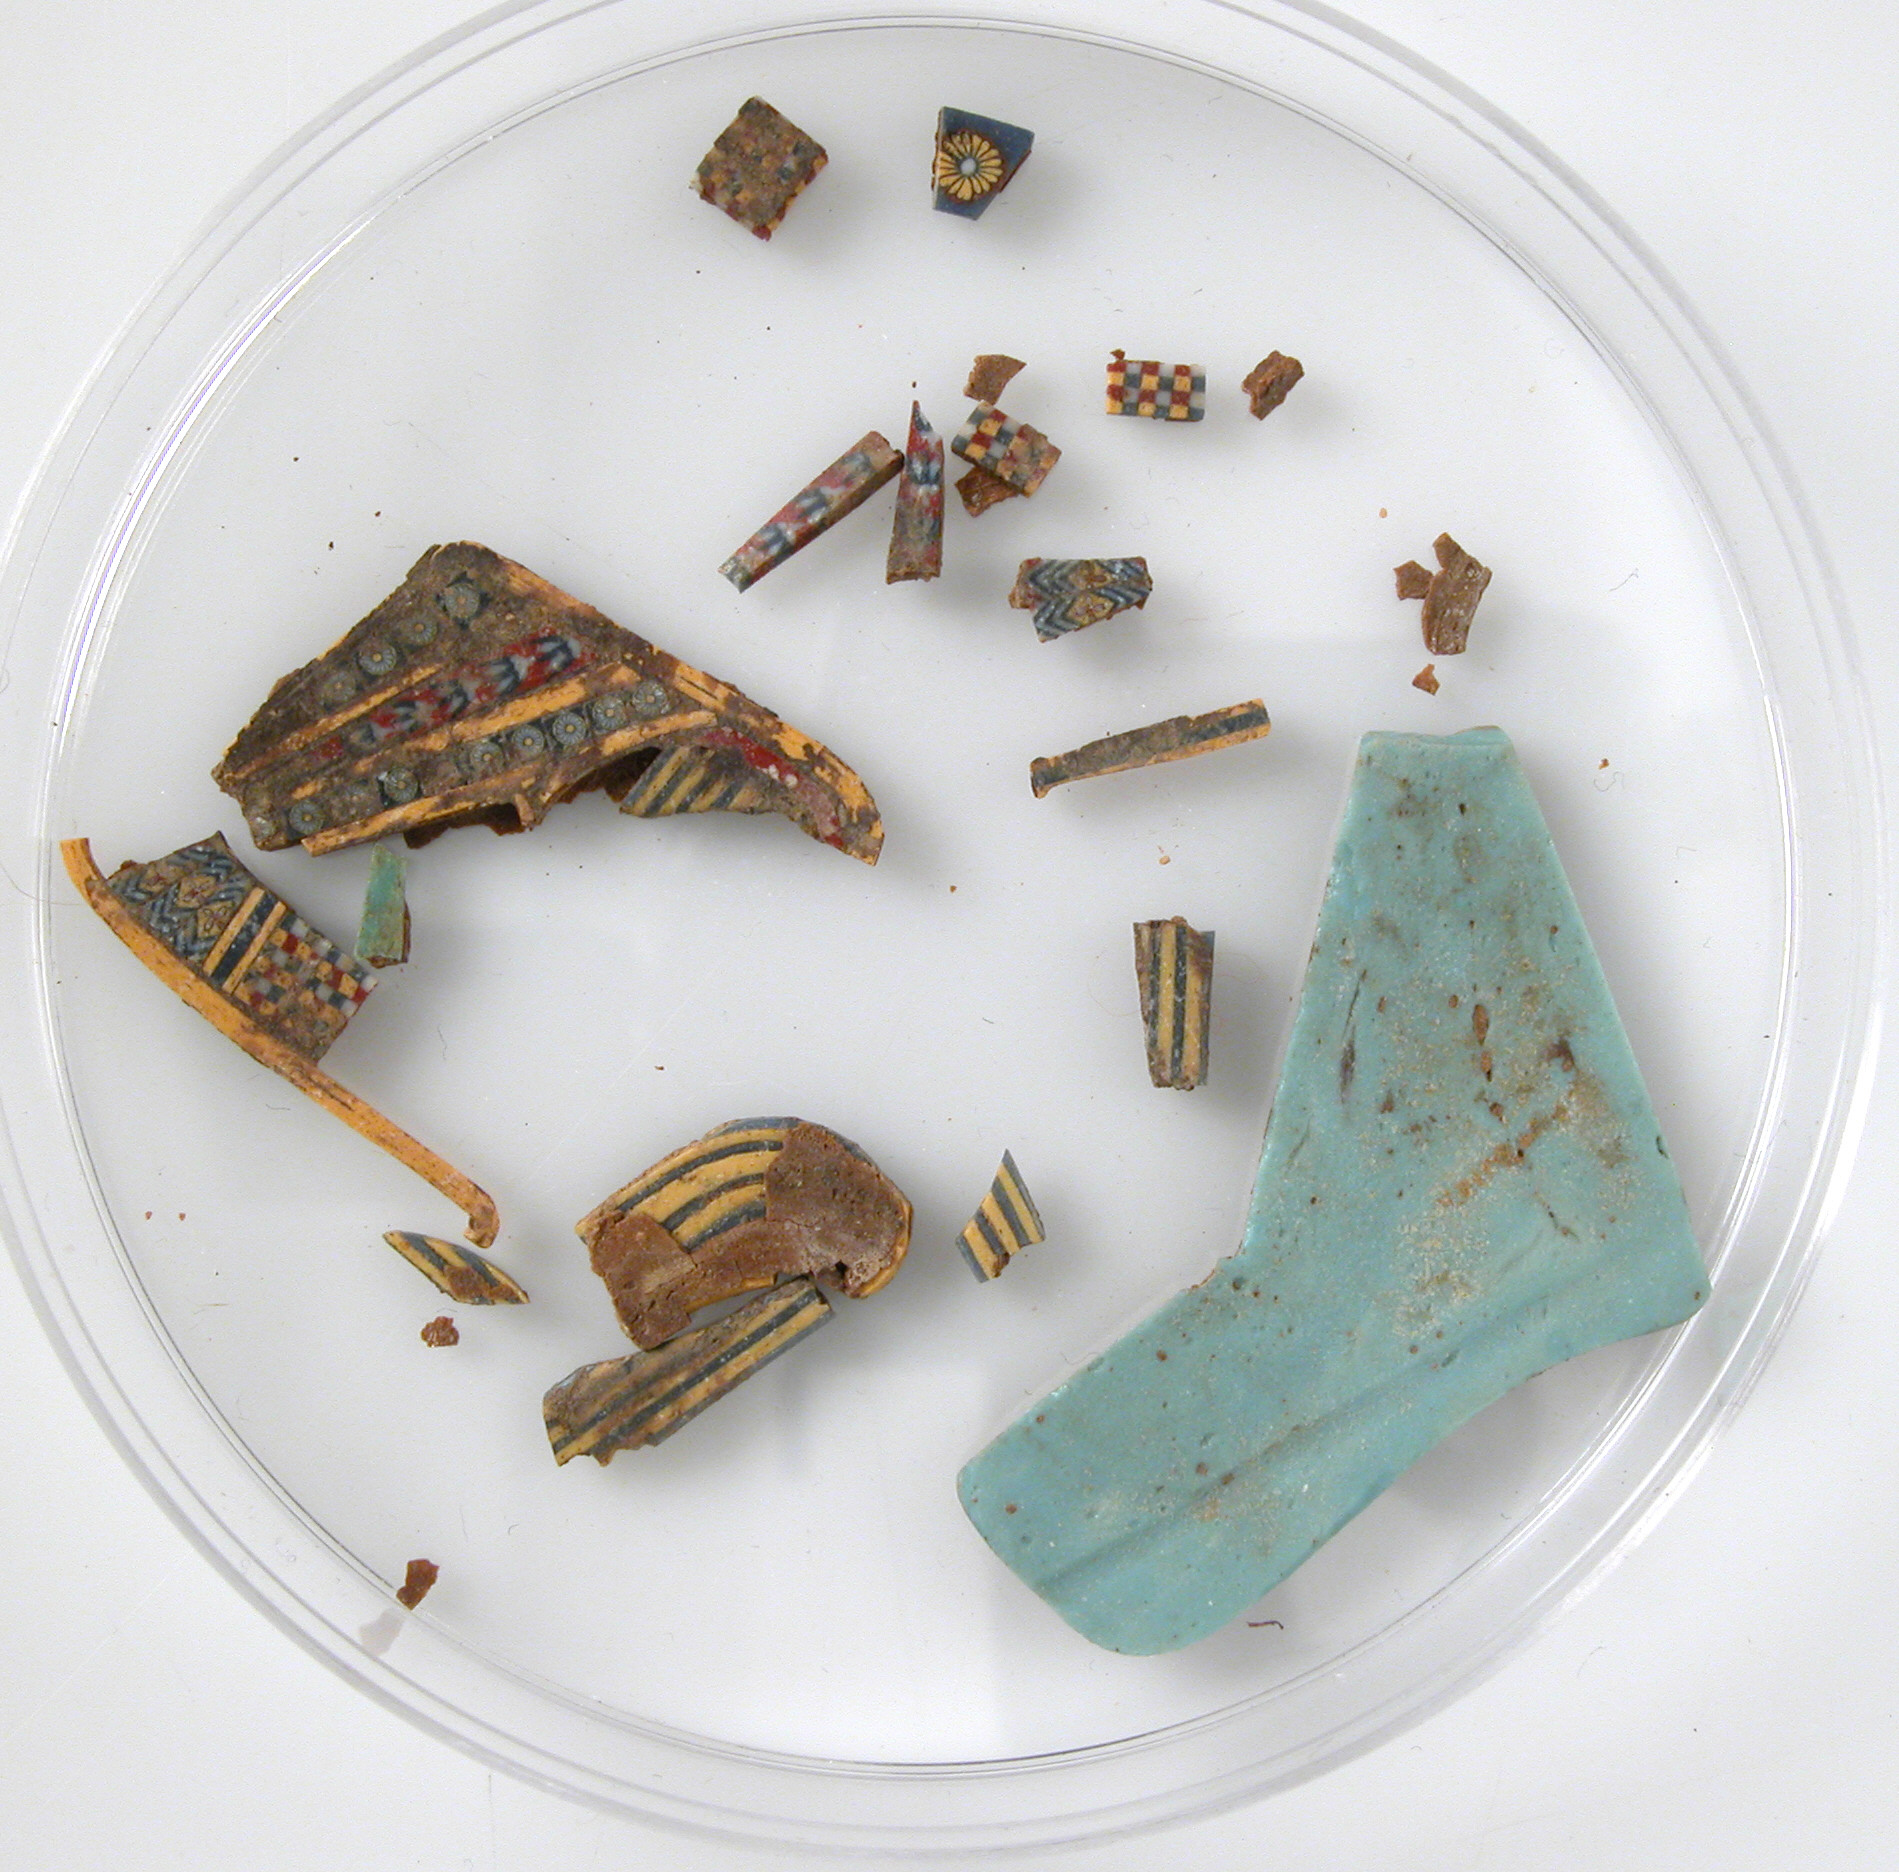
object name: fragment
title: Fragments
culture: coptic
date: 301-700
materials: glass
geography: egypt